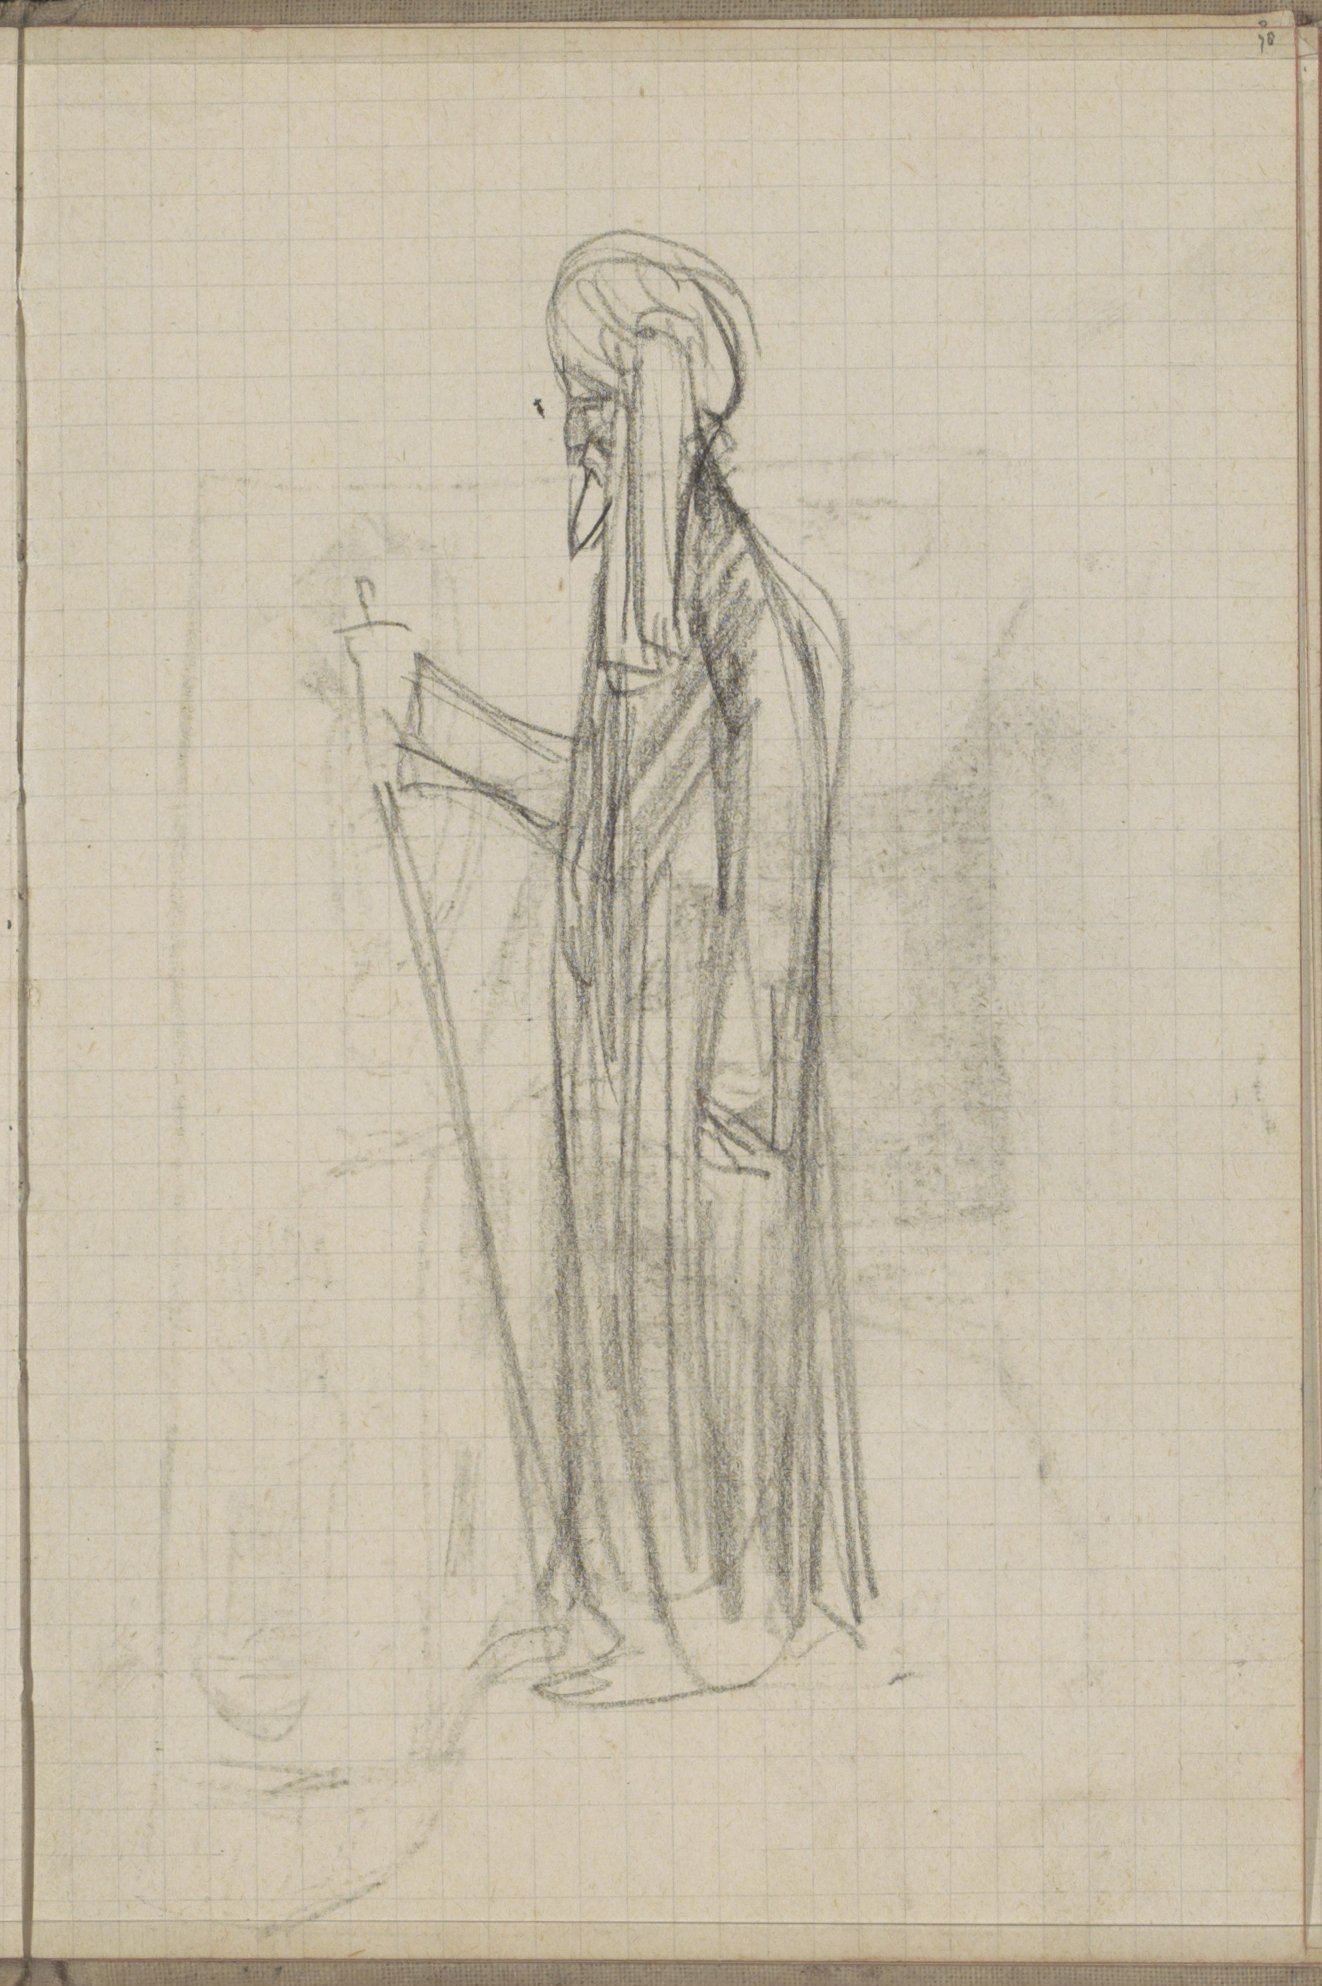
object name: sketchbook leaf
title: Staande figuur met staf in oosterse kleding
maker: marius bauer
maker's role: draughtsman, print maker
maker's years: 1867-1932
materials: chalk, paper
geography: istanbul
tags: asiatic races and peoples, standing figure, walking-stick, staff, adult man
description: Zijaanzicht van man met baard en tulband. Pagina 78 uit een schetsboek met 51 bladen.